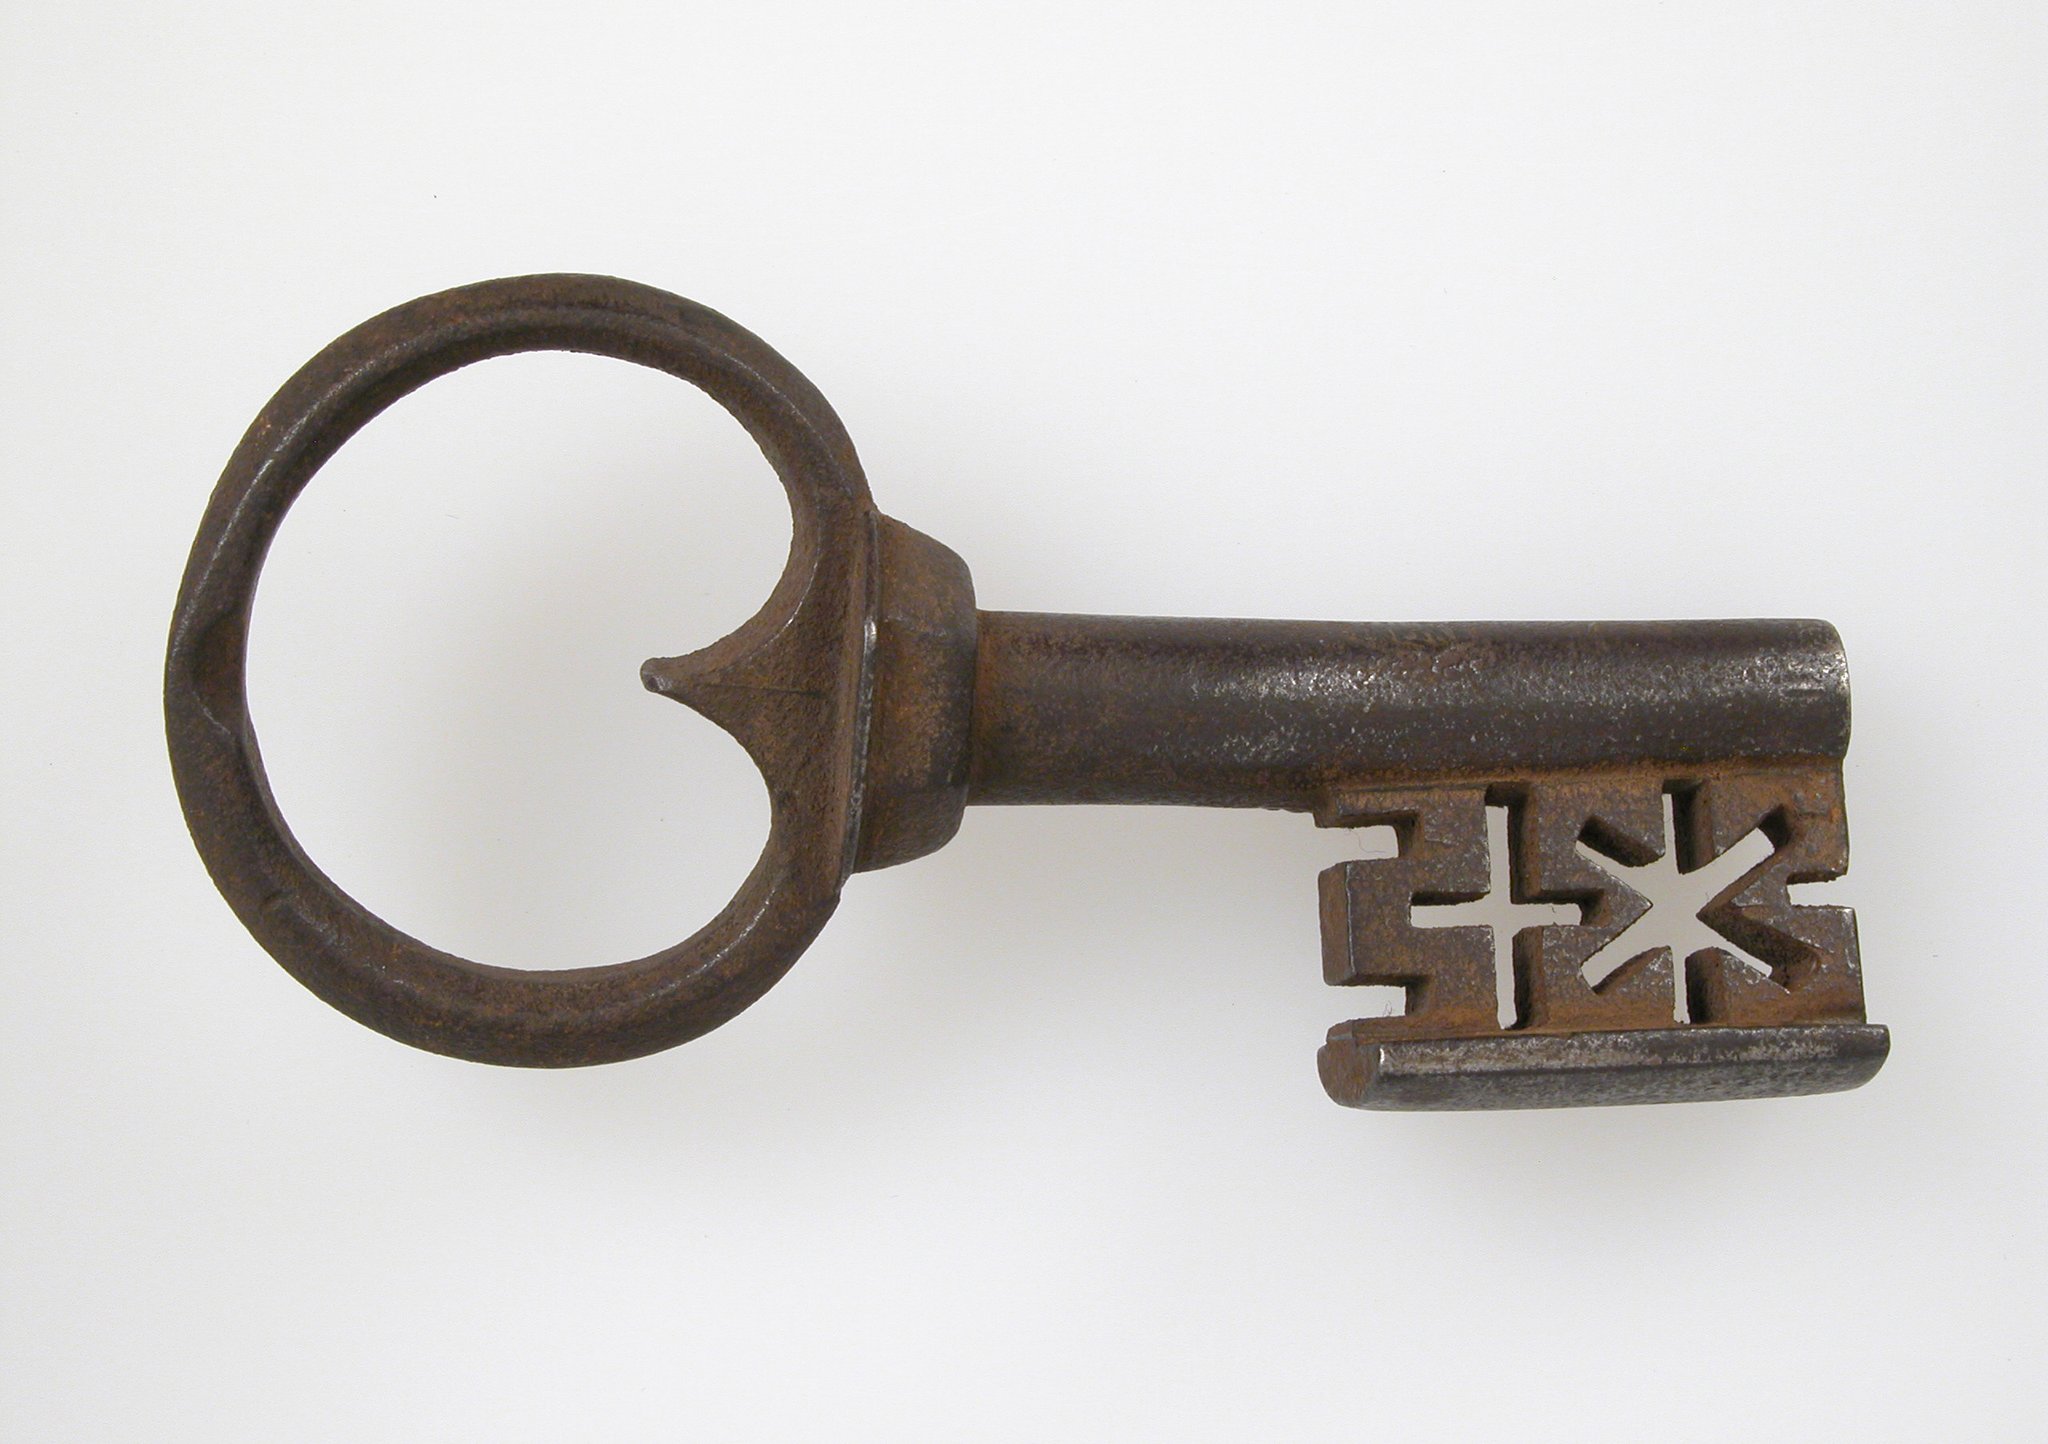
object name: key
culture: german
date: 1401-1600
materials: iron